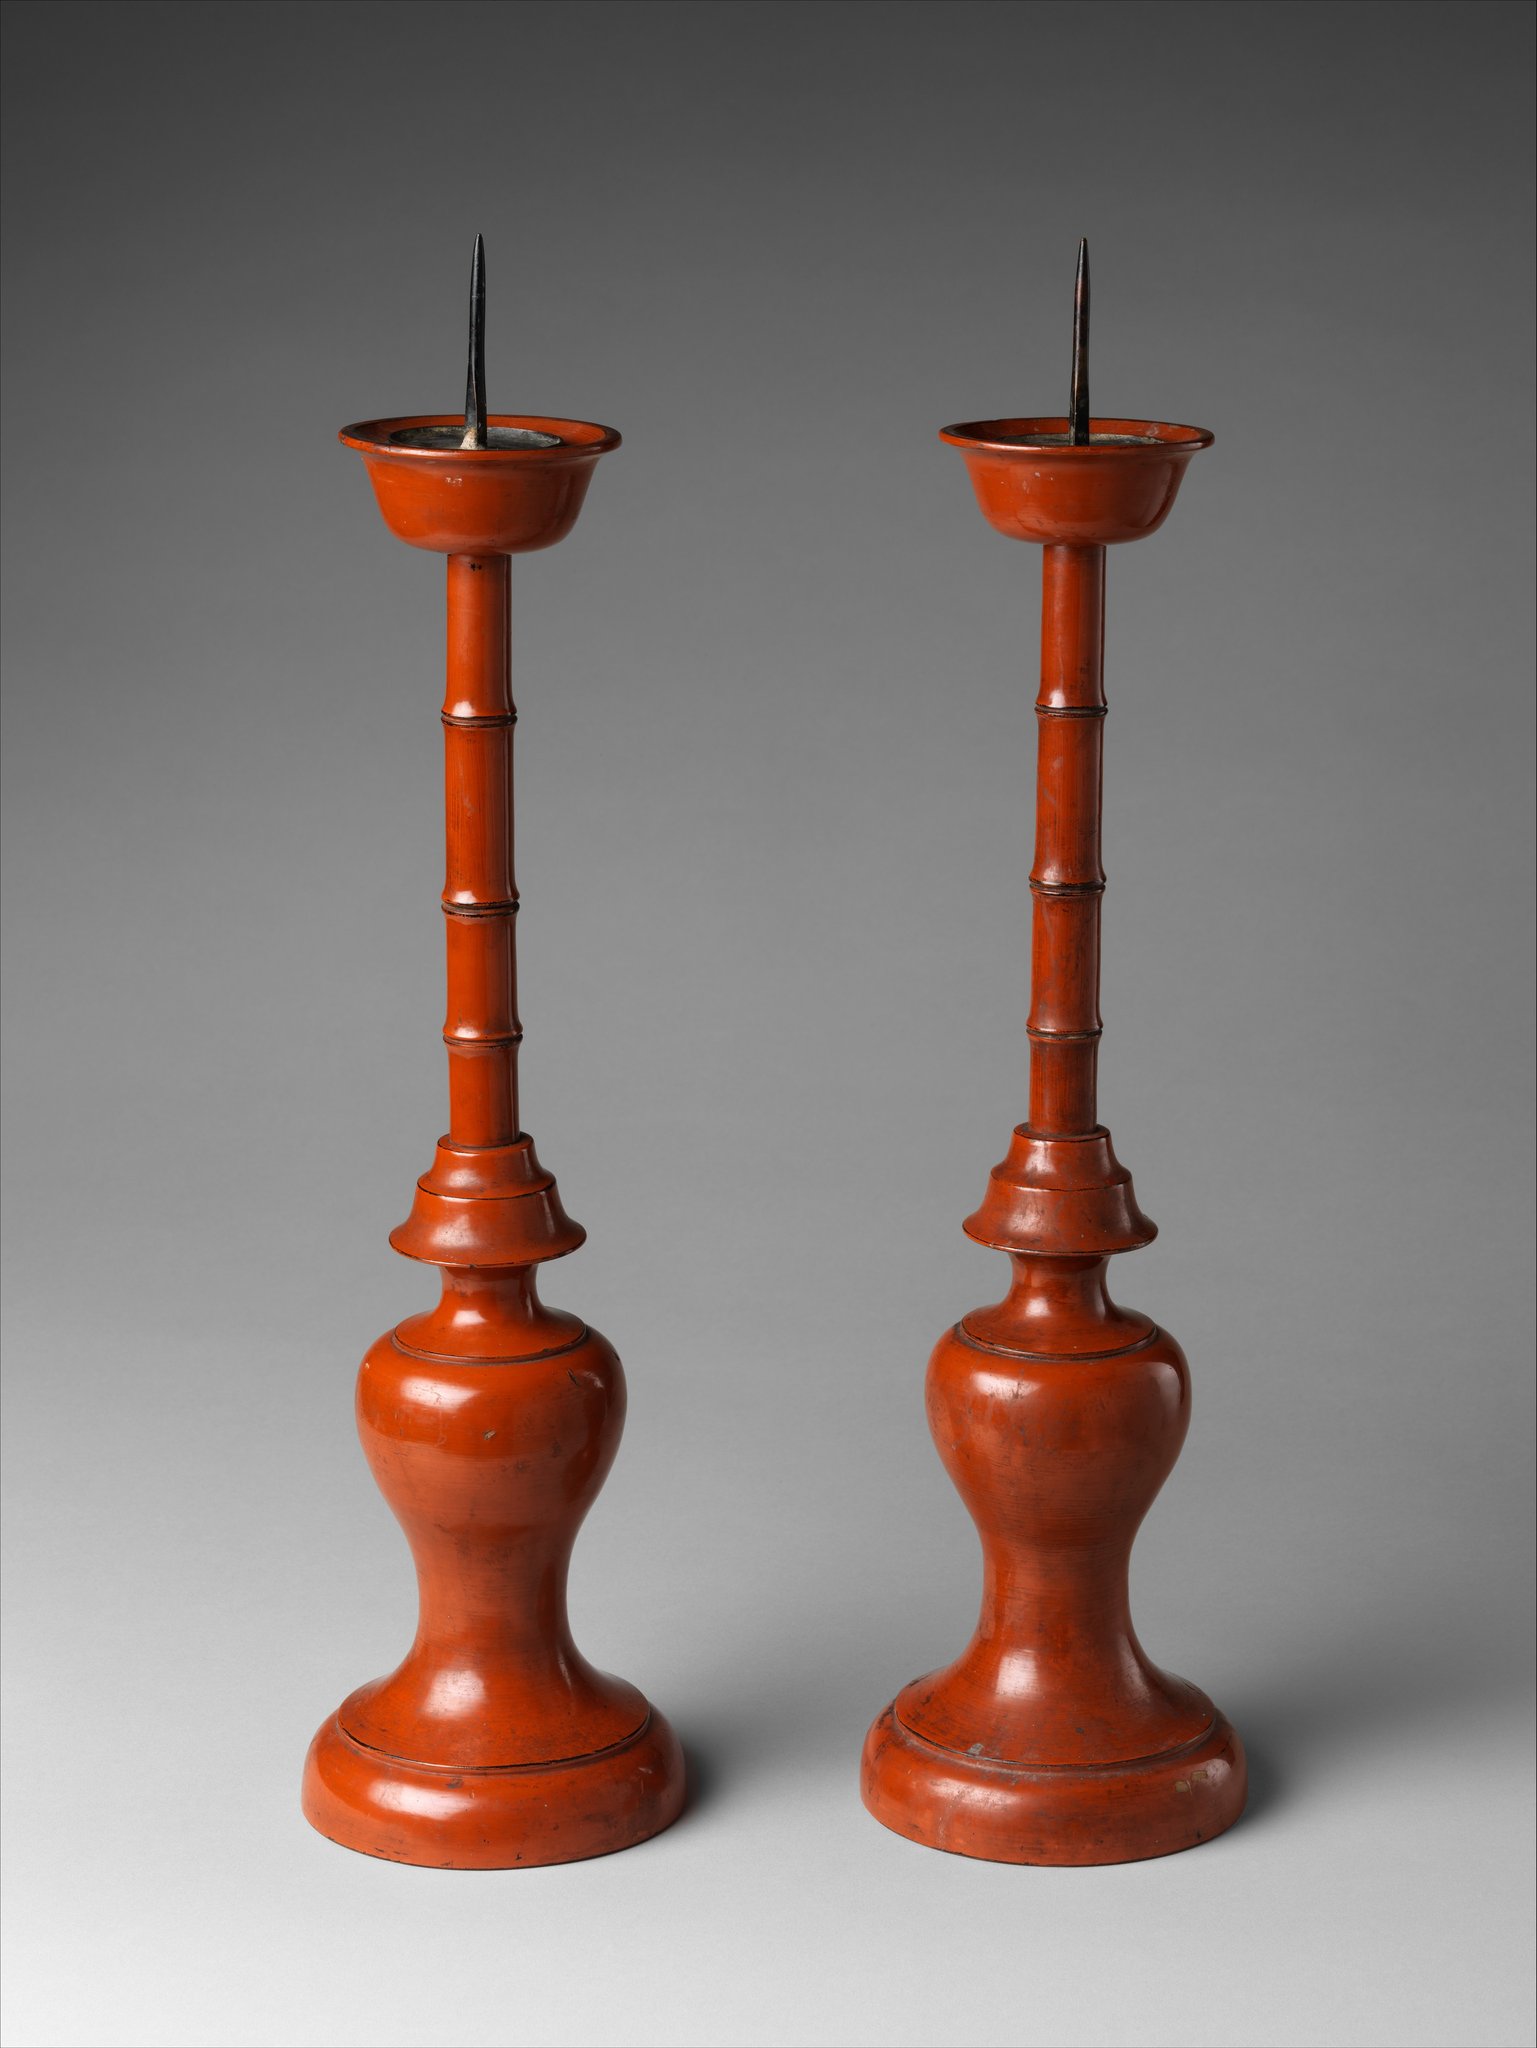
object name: candlestick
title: Pair of Negoro Lacquer Candlesticks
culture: japanese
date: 1567-1600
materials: lacquer, wood